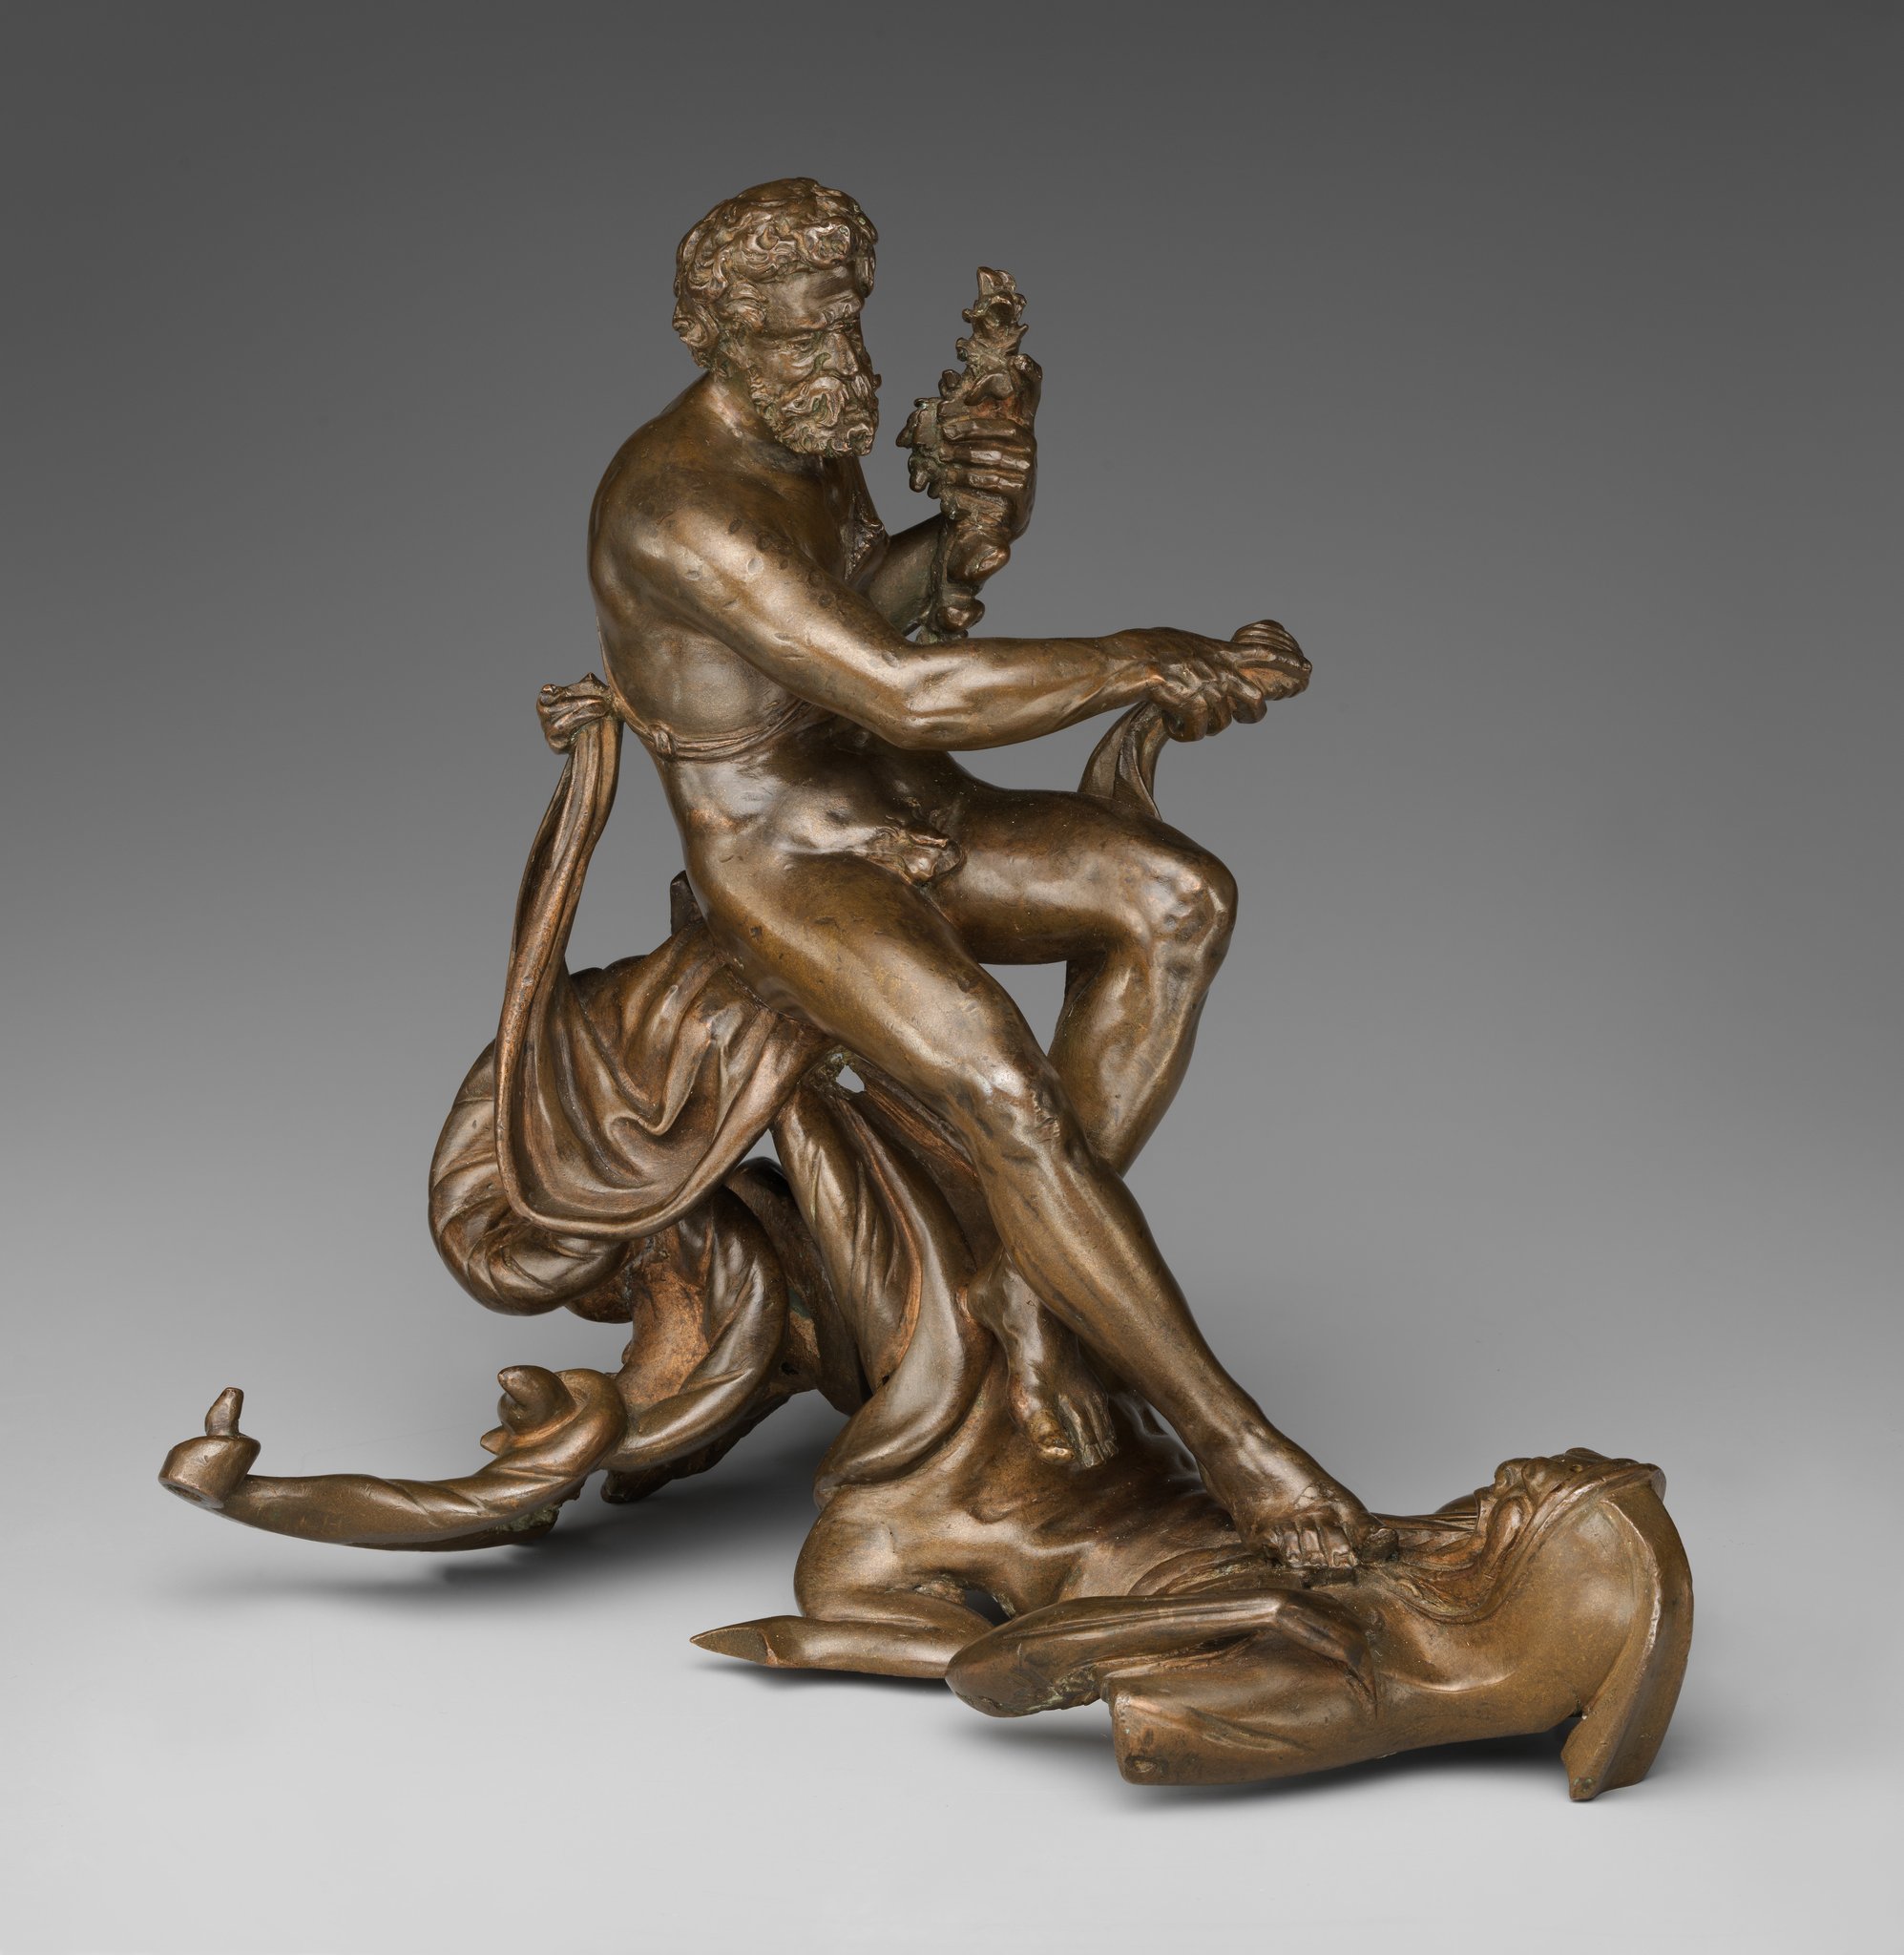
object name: statuette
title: Hercules Overcoming Nereus On His Way to the Garden of the Hesperides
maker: adriaen de vries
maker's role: artist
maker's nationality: netherlandish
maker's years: 1545-1626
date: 1602-1612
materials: bronze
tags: hercules